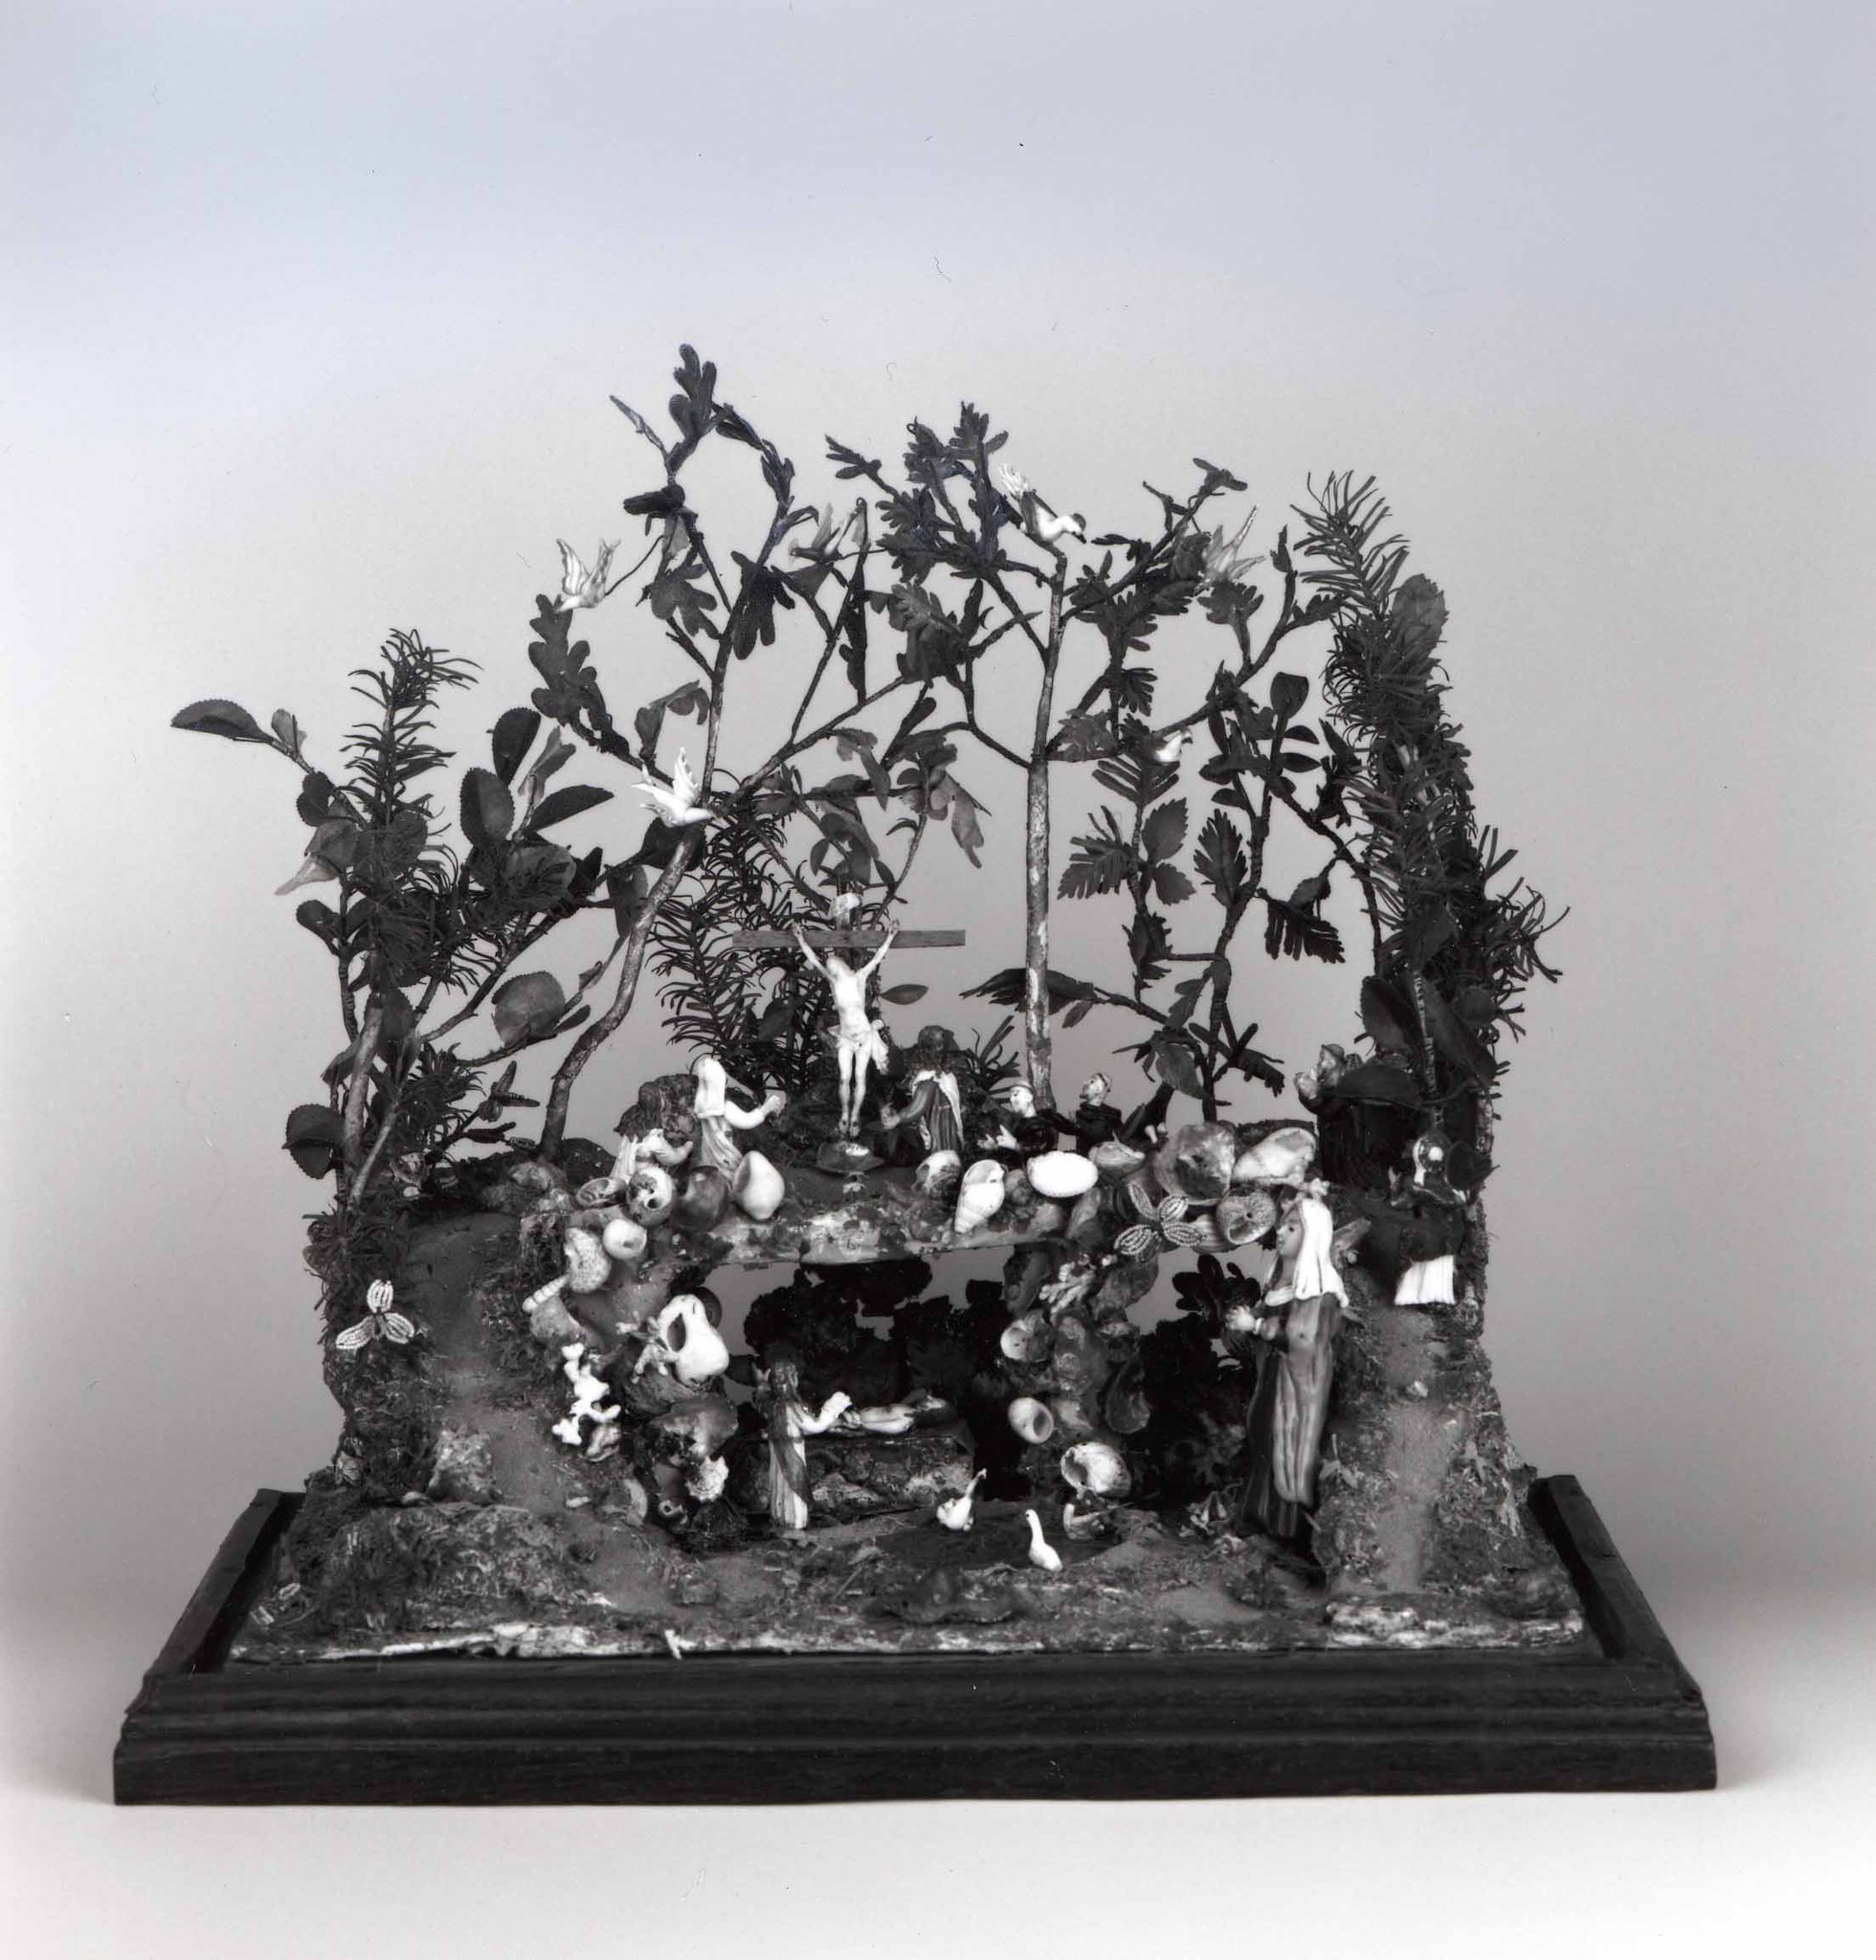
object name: figurine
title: The Crucifixion and the Entombment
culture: french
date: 1701-1800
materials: cardboard, cork, glass, ivory, paint, paper, shell, metal, wood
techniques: lampwork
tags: christ,entombment